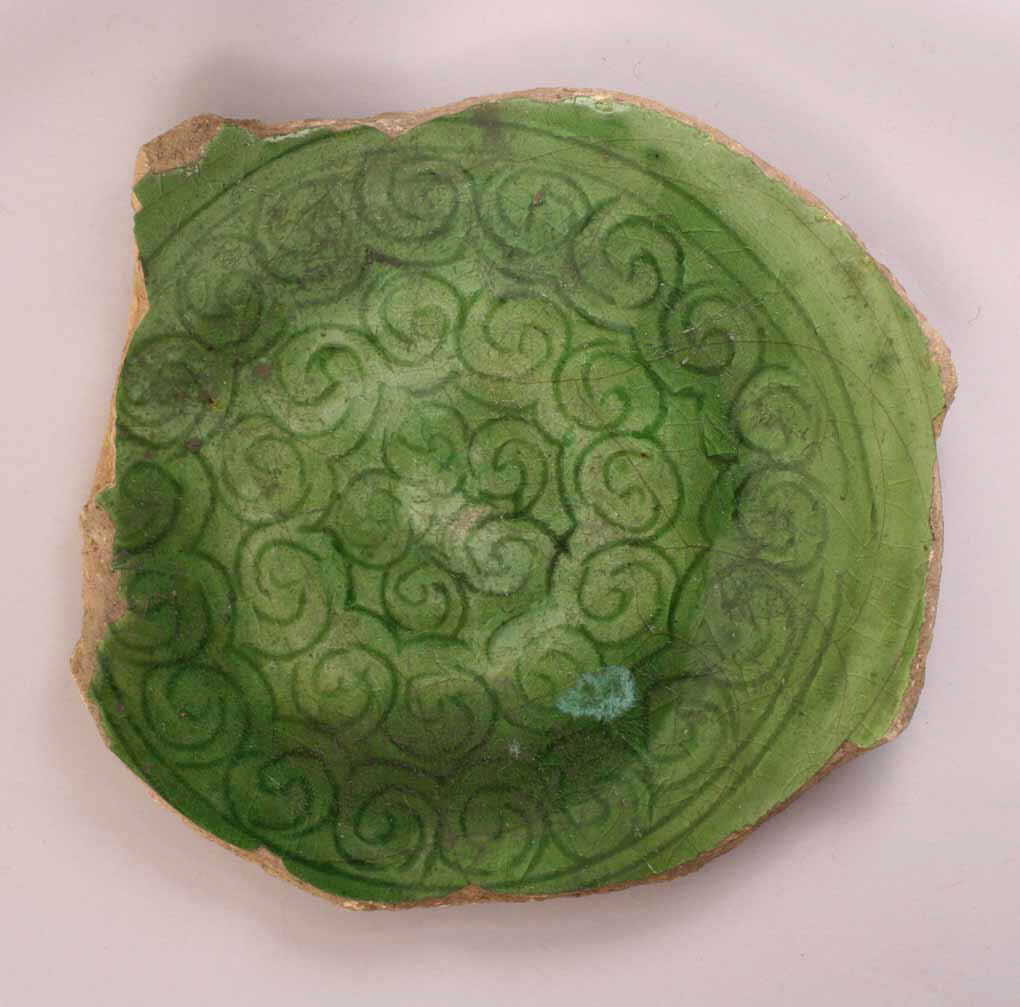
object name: ceramic fragment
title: Fragment of a Bowl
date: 1201-1400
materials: earthenware, glaze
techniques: incising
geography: egypt